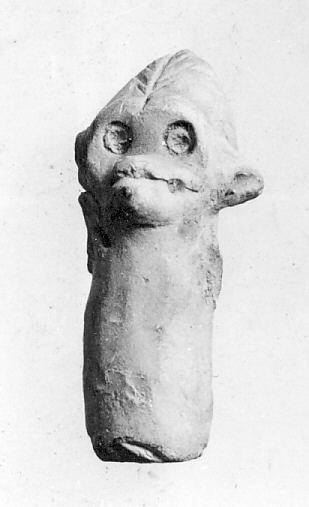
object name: figurine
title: Head of a Monkey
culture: central asian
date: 1101-1133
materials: clay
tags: monkeys